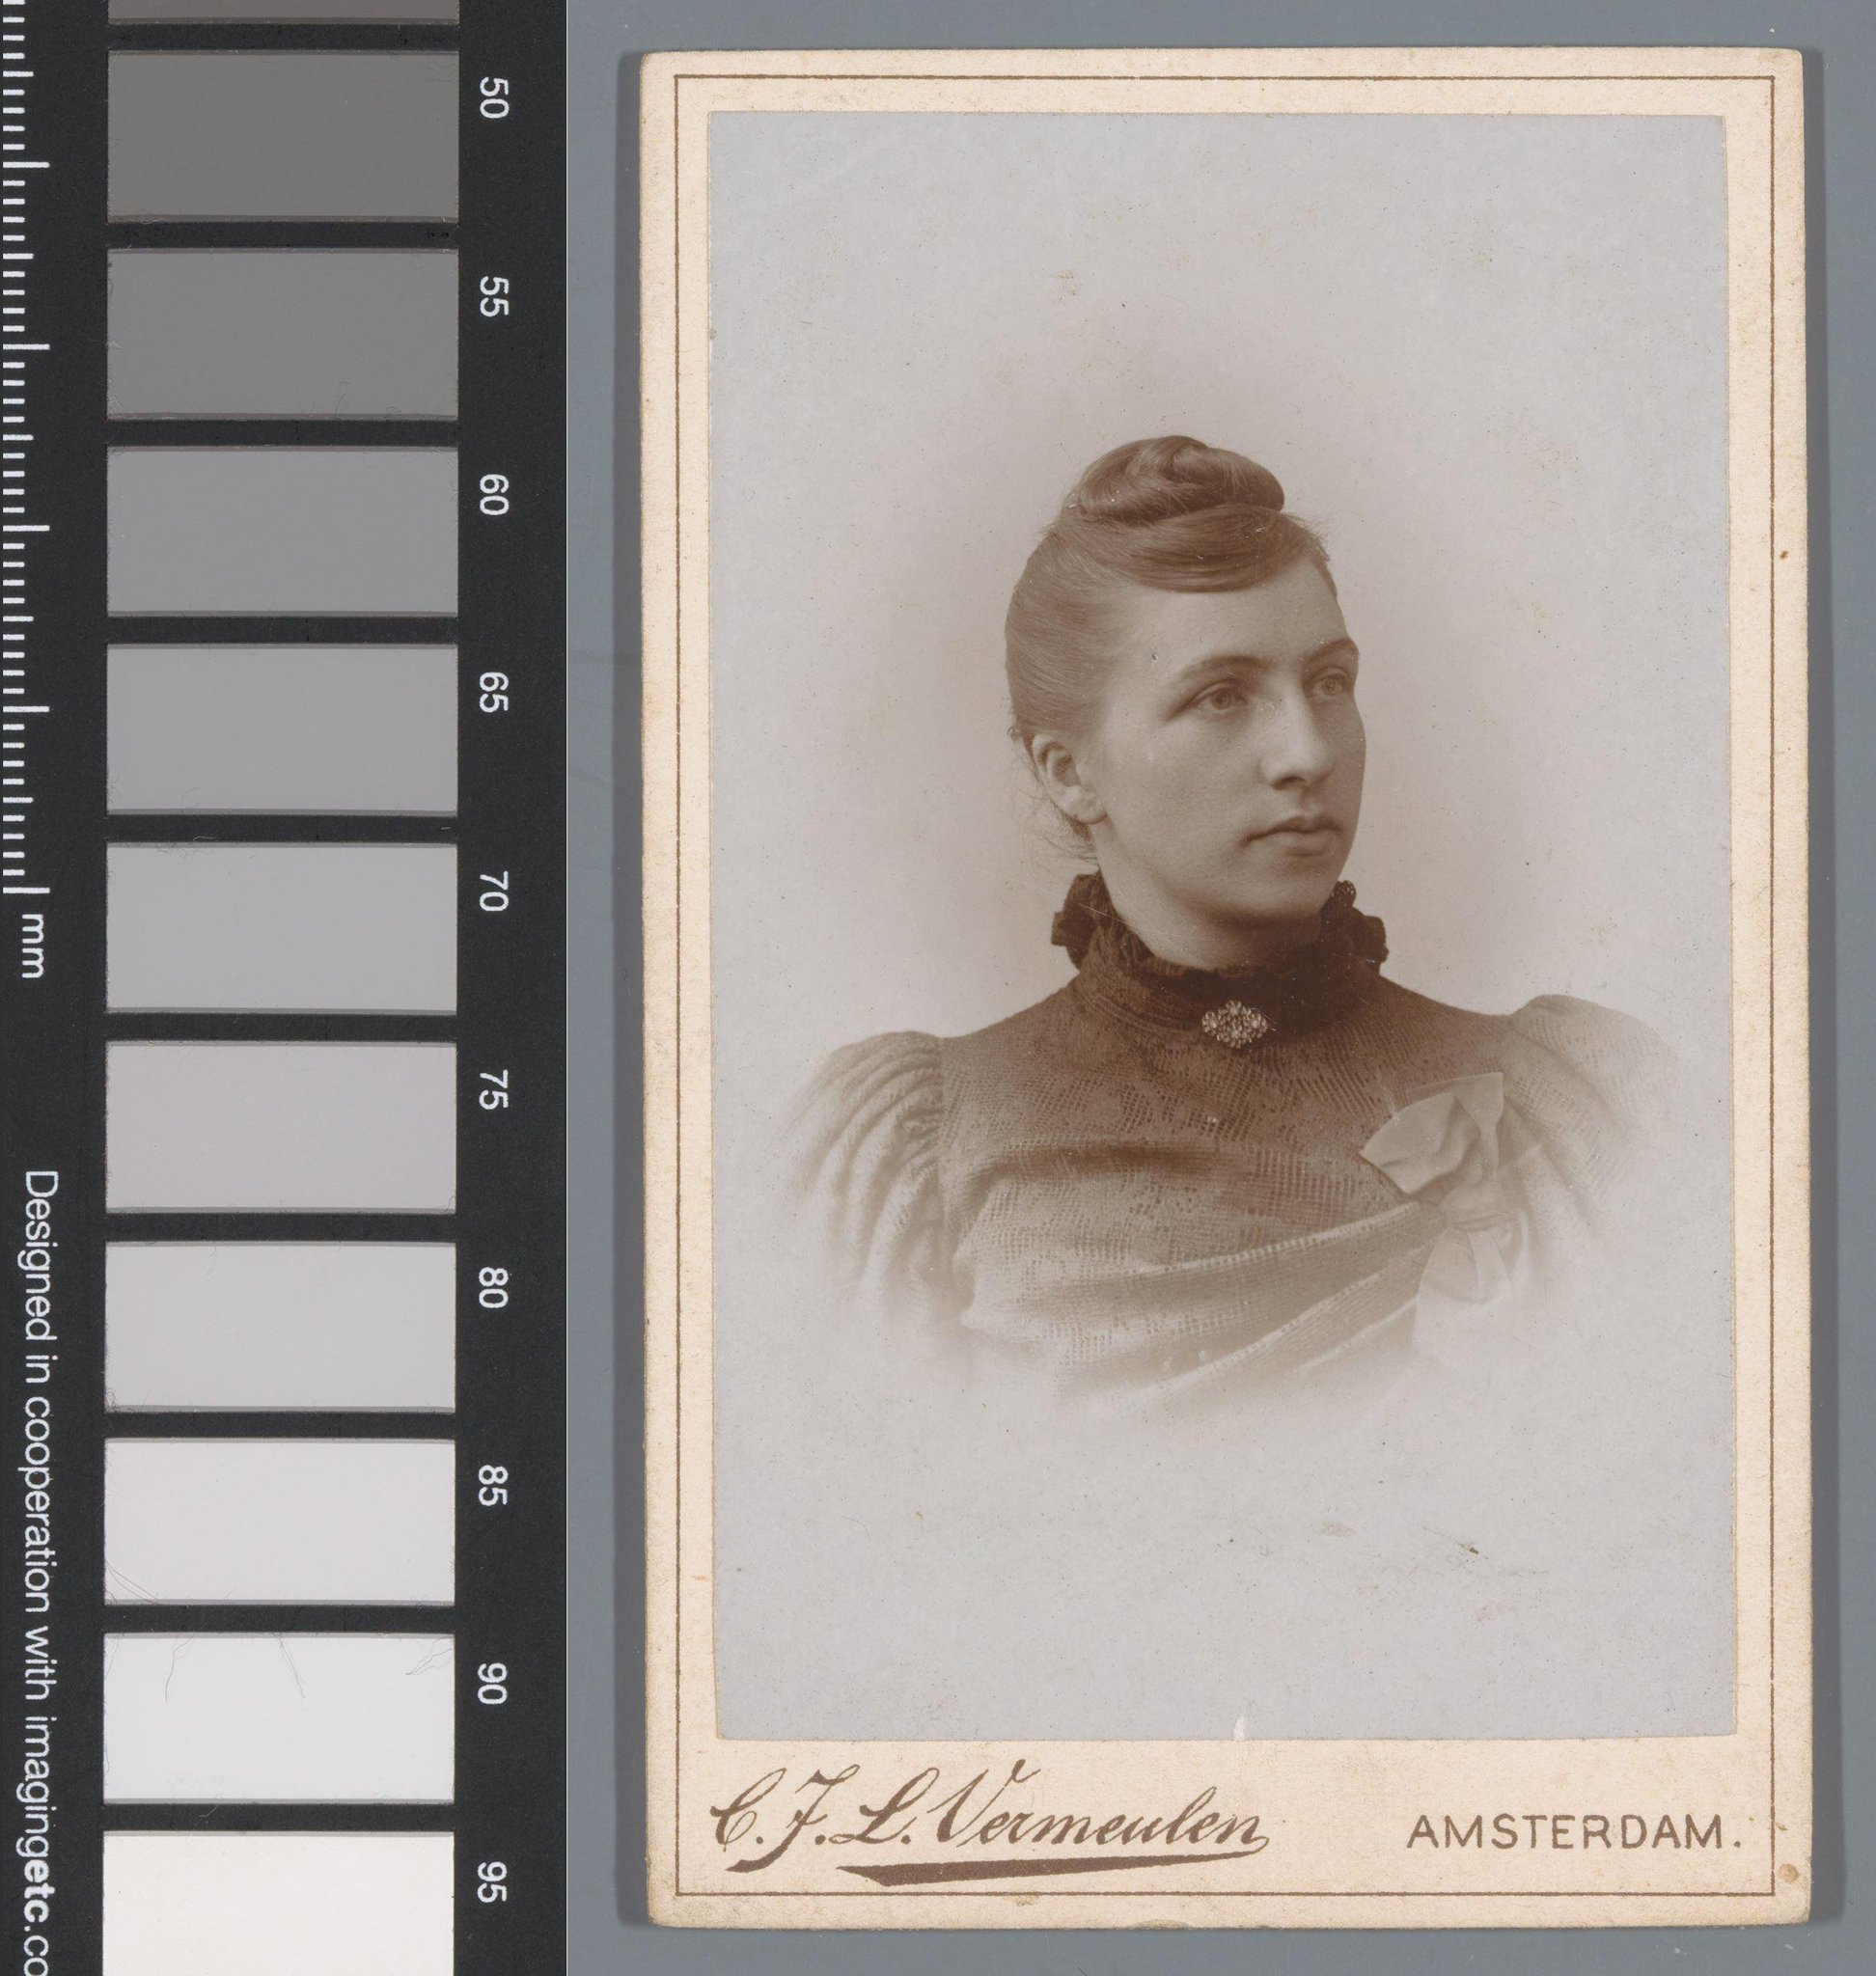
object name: photograph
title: Portret van een onbekende vrouw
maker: cornelis johannes lodewicus vermeulen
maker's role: fotograaf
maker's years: 1861-1936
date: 1888-1896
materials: cardboard, photographic support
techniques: collodion silver print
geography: amsterdam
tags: historical persons - bb - woman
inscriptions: inscription: ‘C. J. L. Vermeulen/ Photographische Ateliers./ AMSTERDAM./ Heerenstraat 6 &/ Heiligenweg hoek Singel./ Specialiteit in/ vergrootingen.’